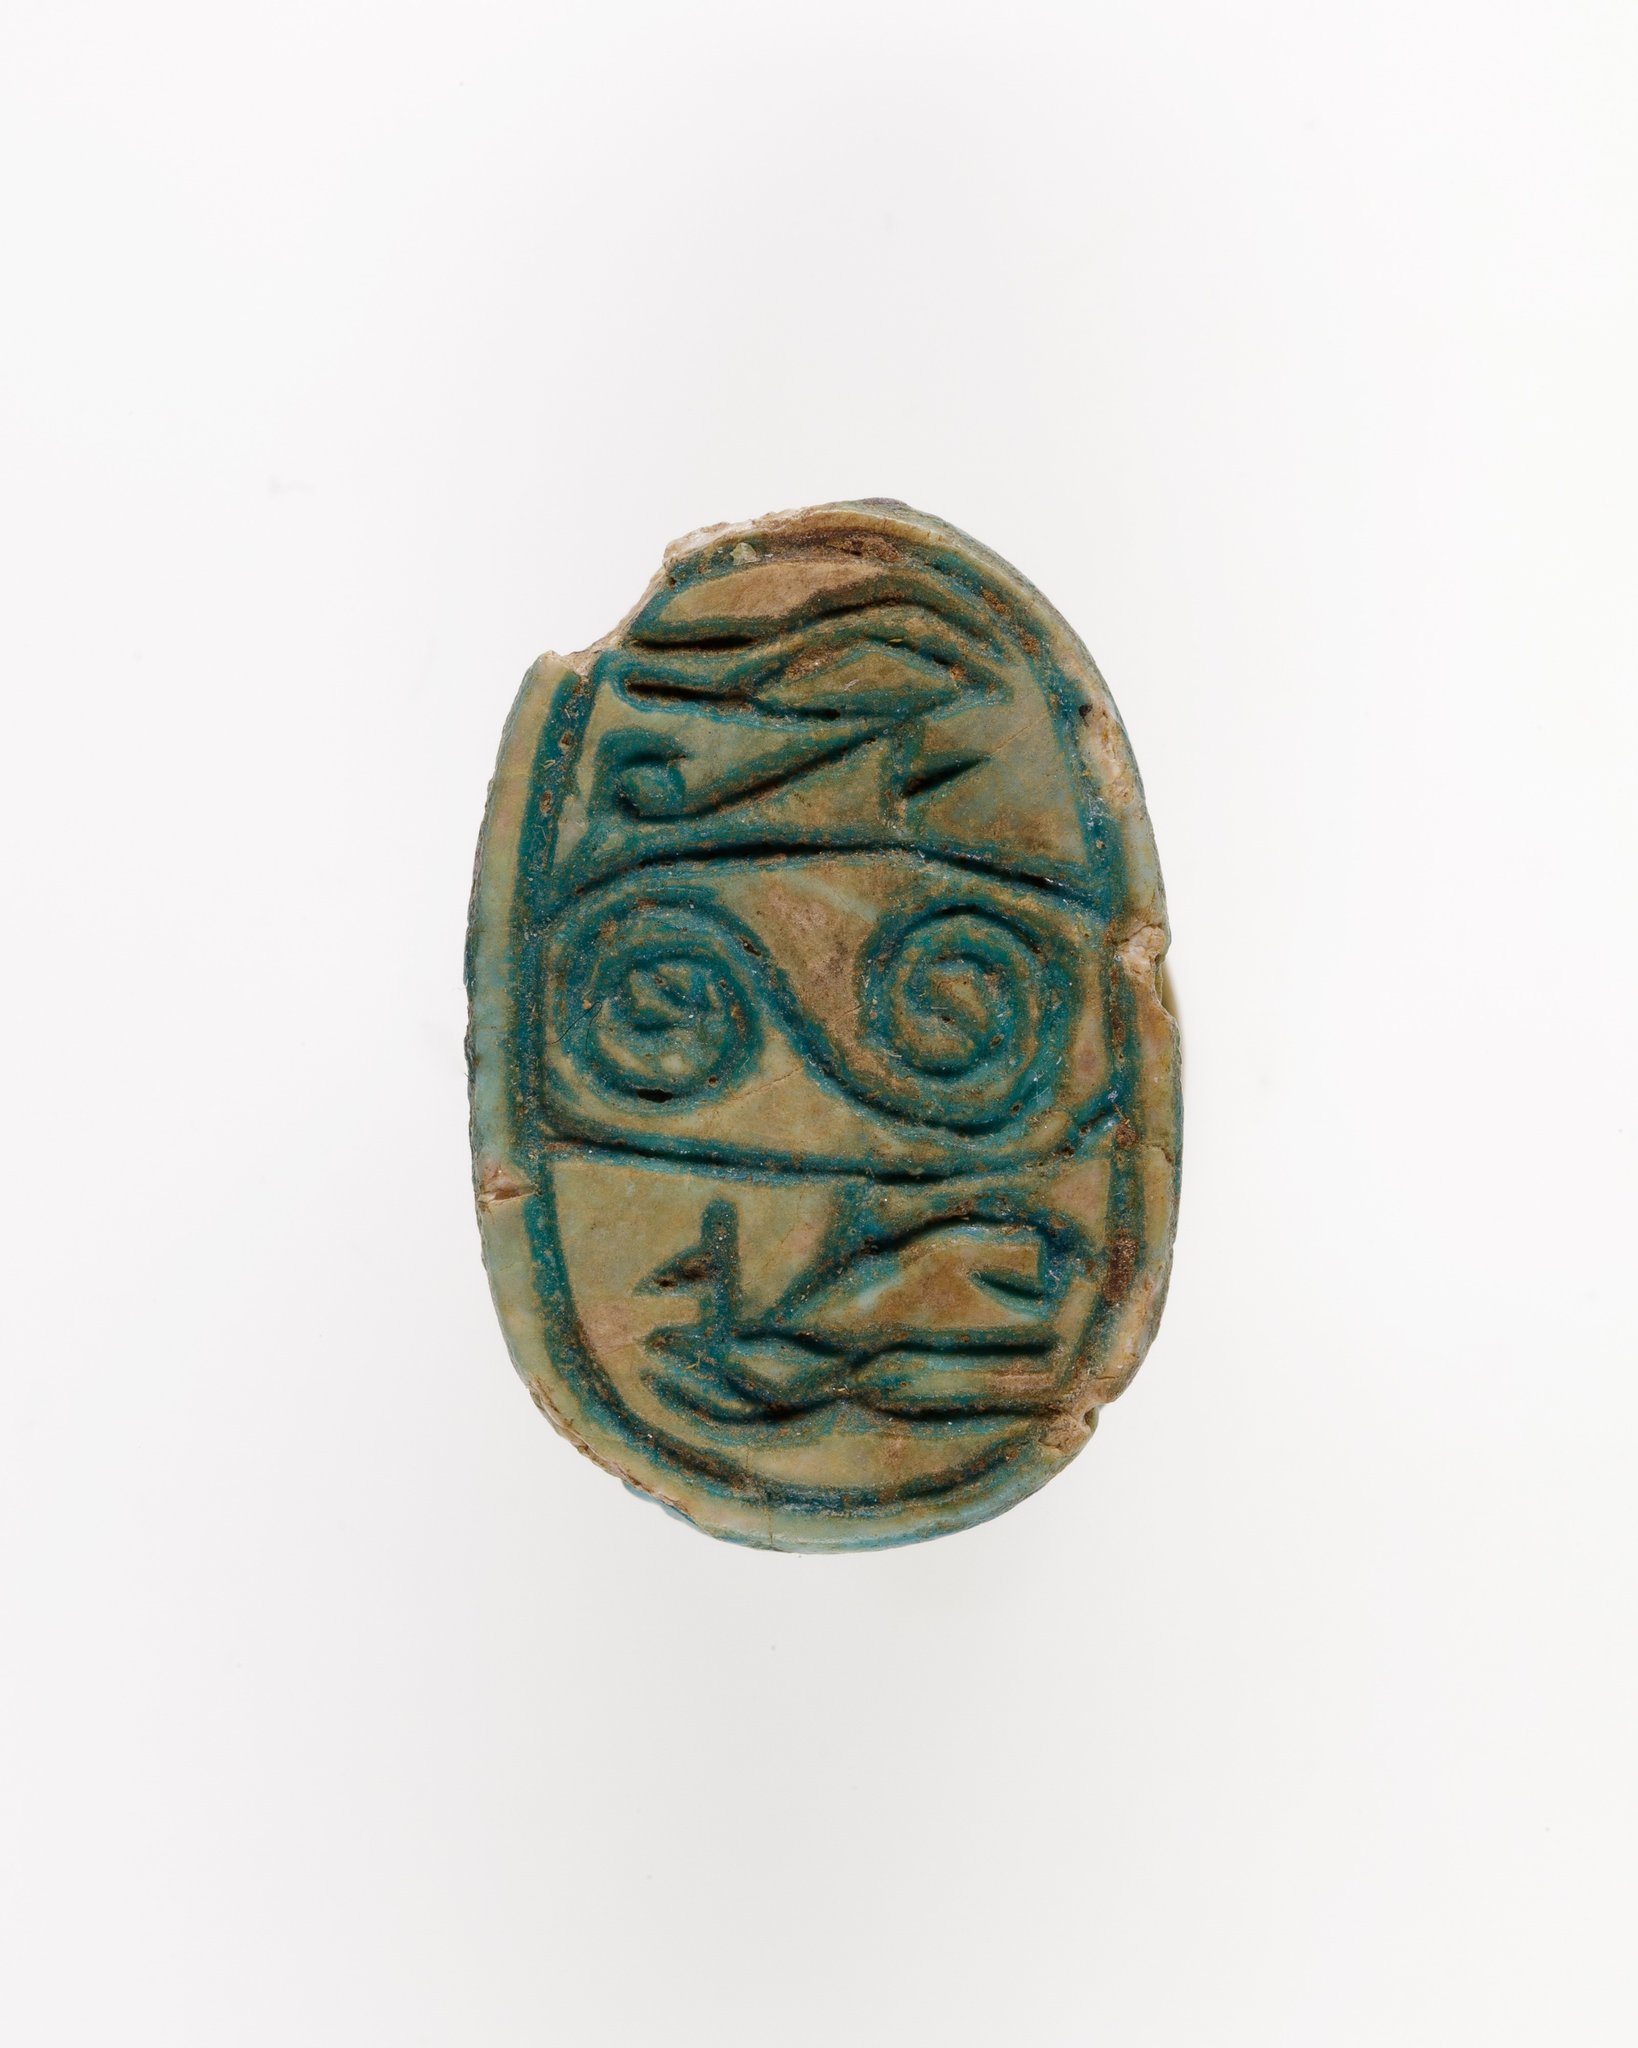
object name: scarab, scroll, wedjat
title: Scarab with Wedjat and Scroll Decoration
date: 1850-1640 BCE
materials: stone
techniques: glazing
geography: egypt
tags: hieroglyphs,scarabs